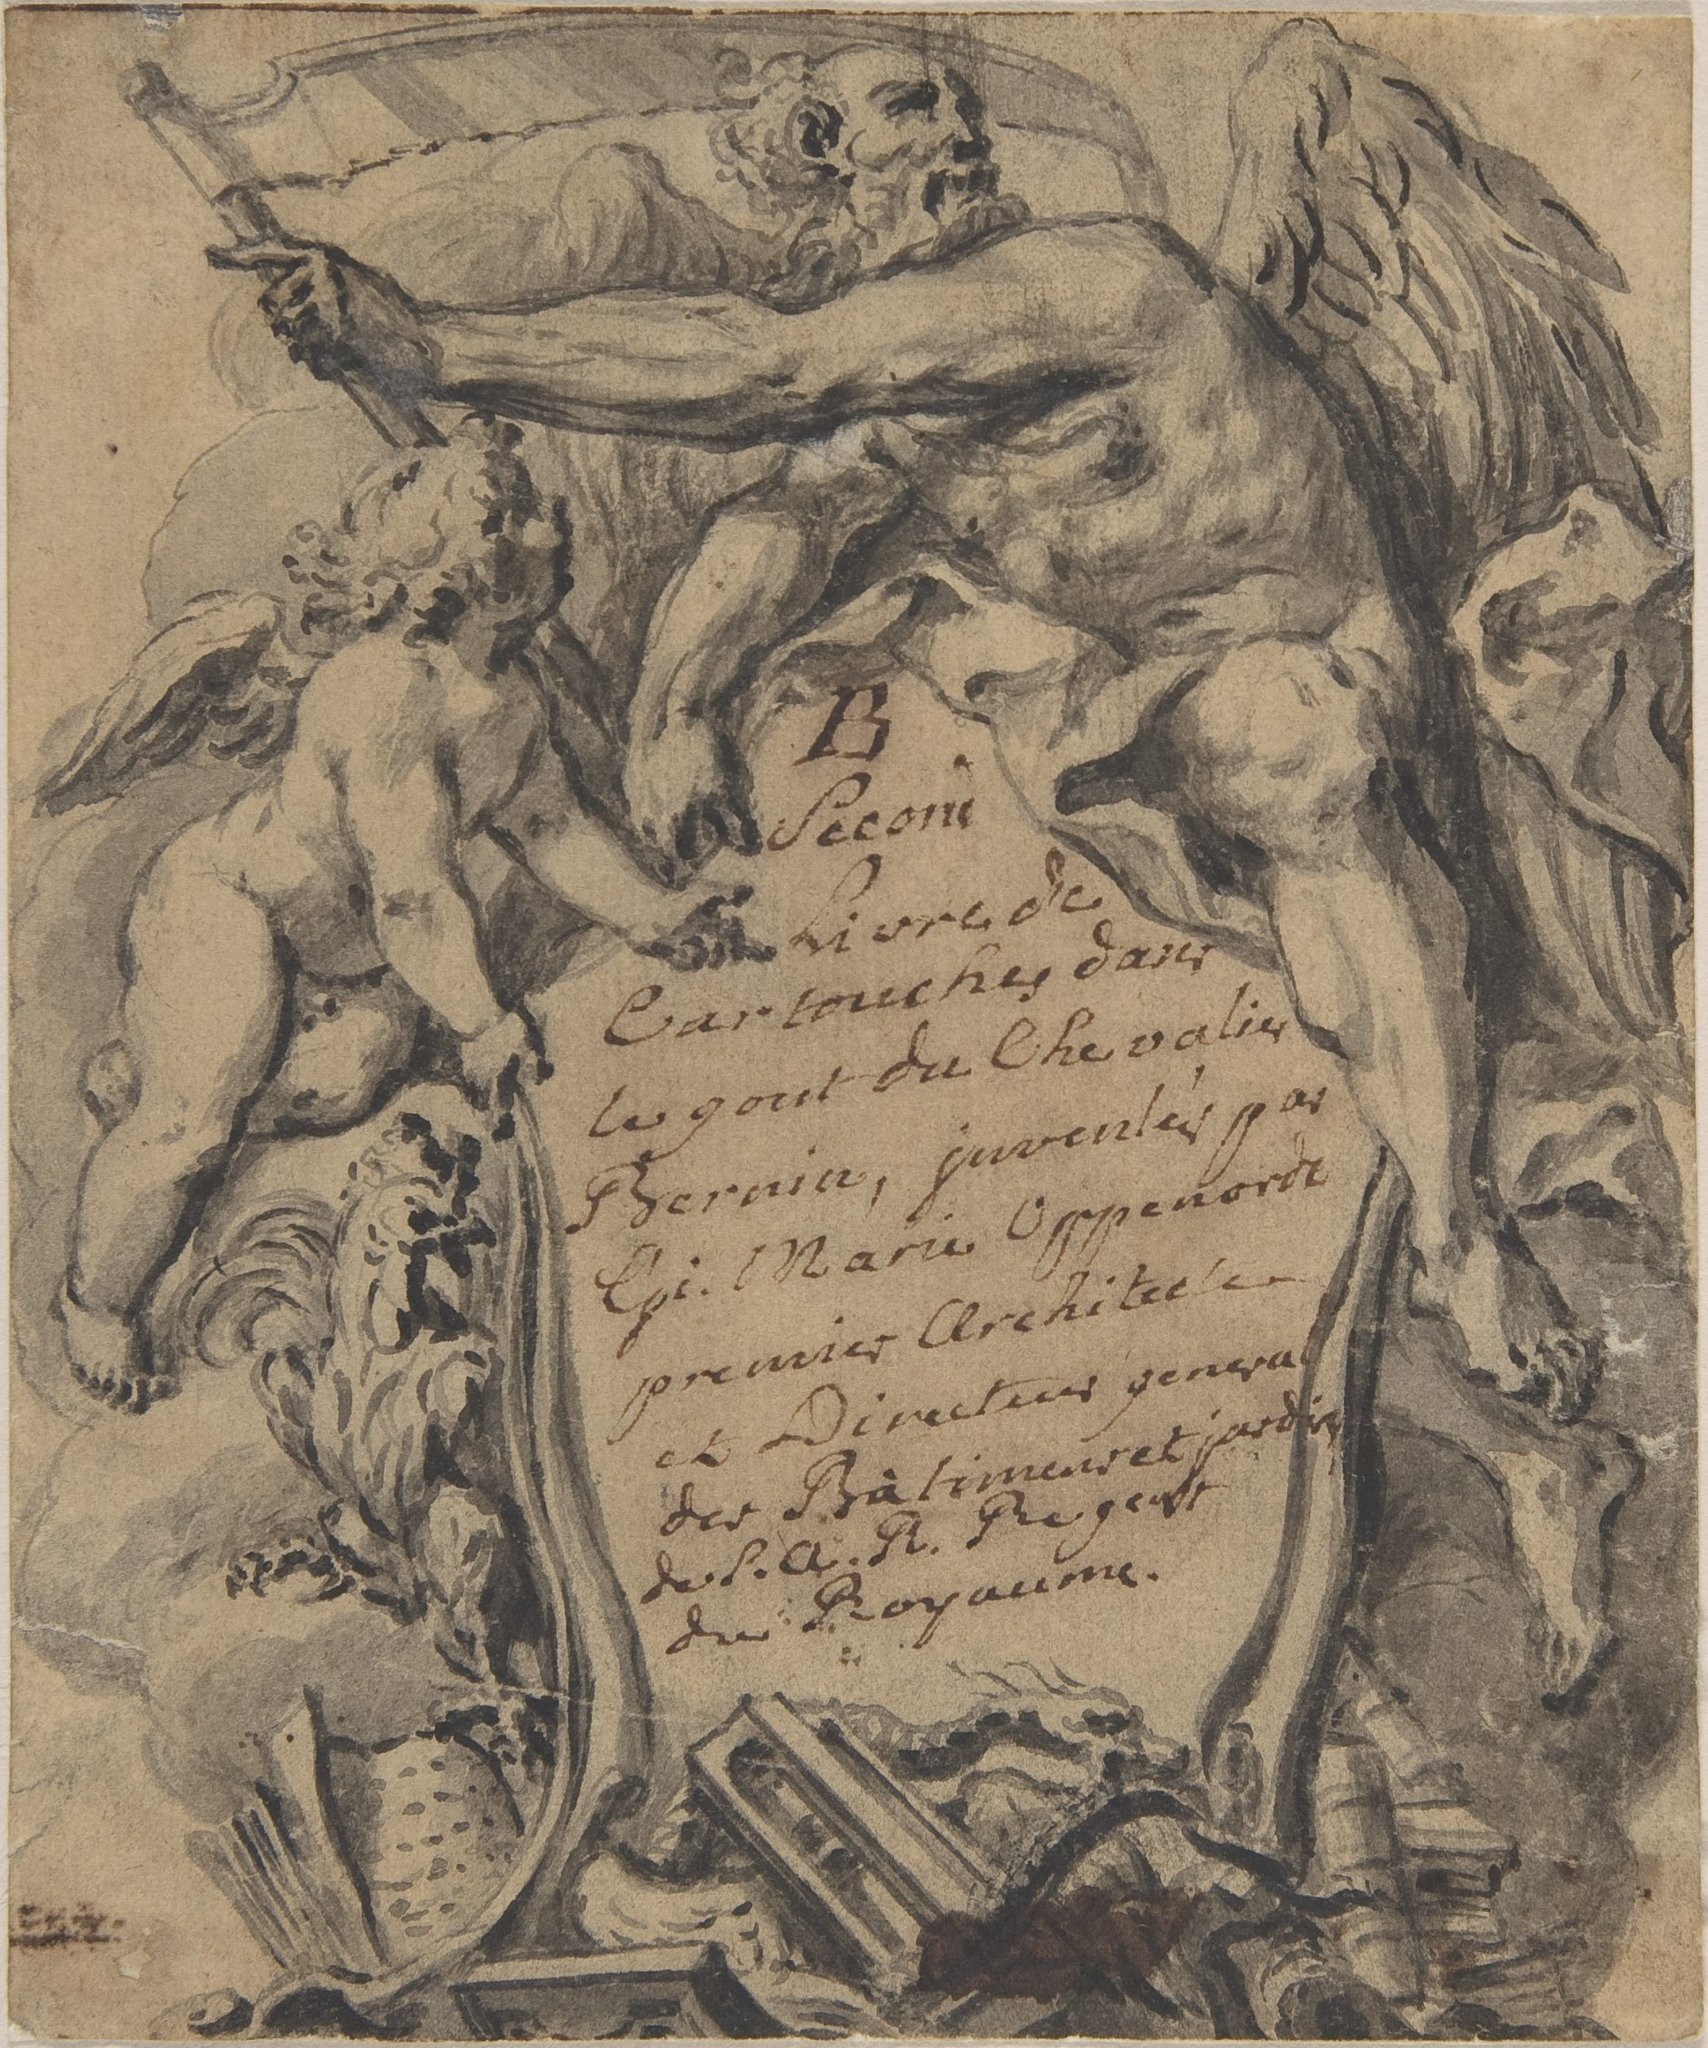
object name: drawing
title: Study for a Cartouche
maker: gilles-marie oppenord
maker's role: artist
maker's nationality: french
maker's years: 1672-1742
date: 1672-1742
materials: ink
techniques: brush, pen, wash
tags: cartouches